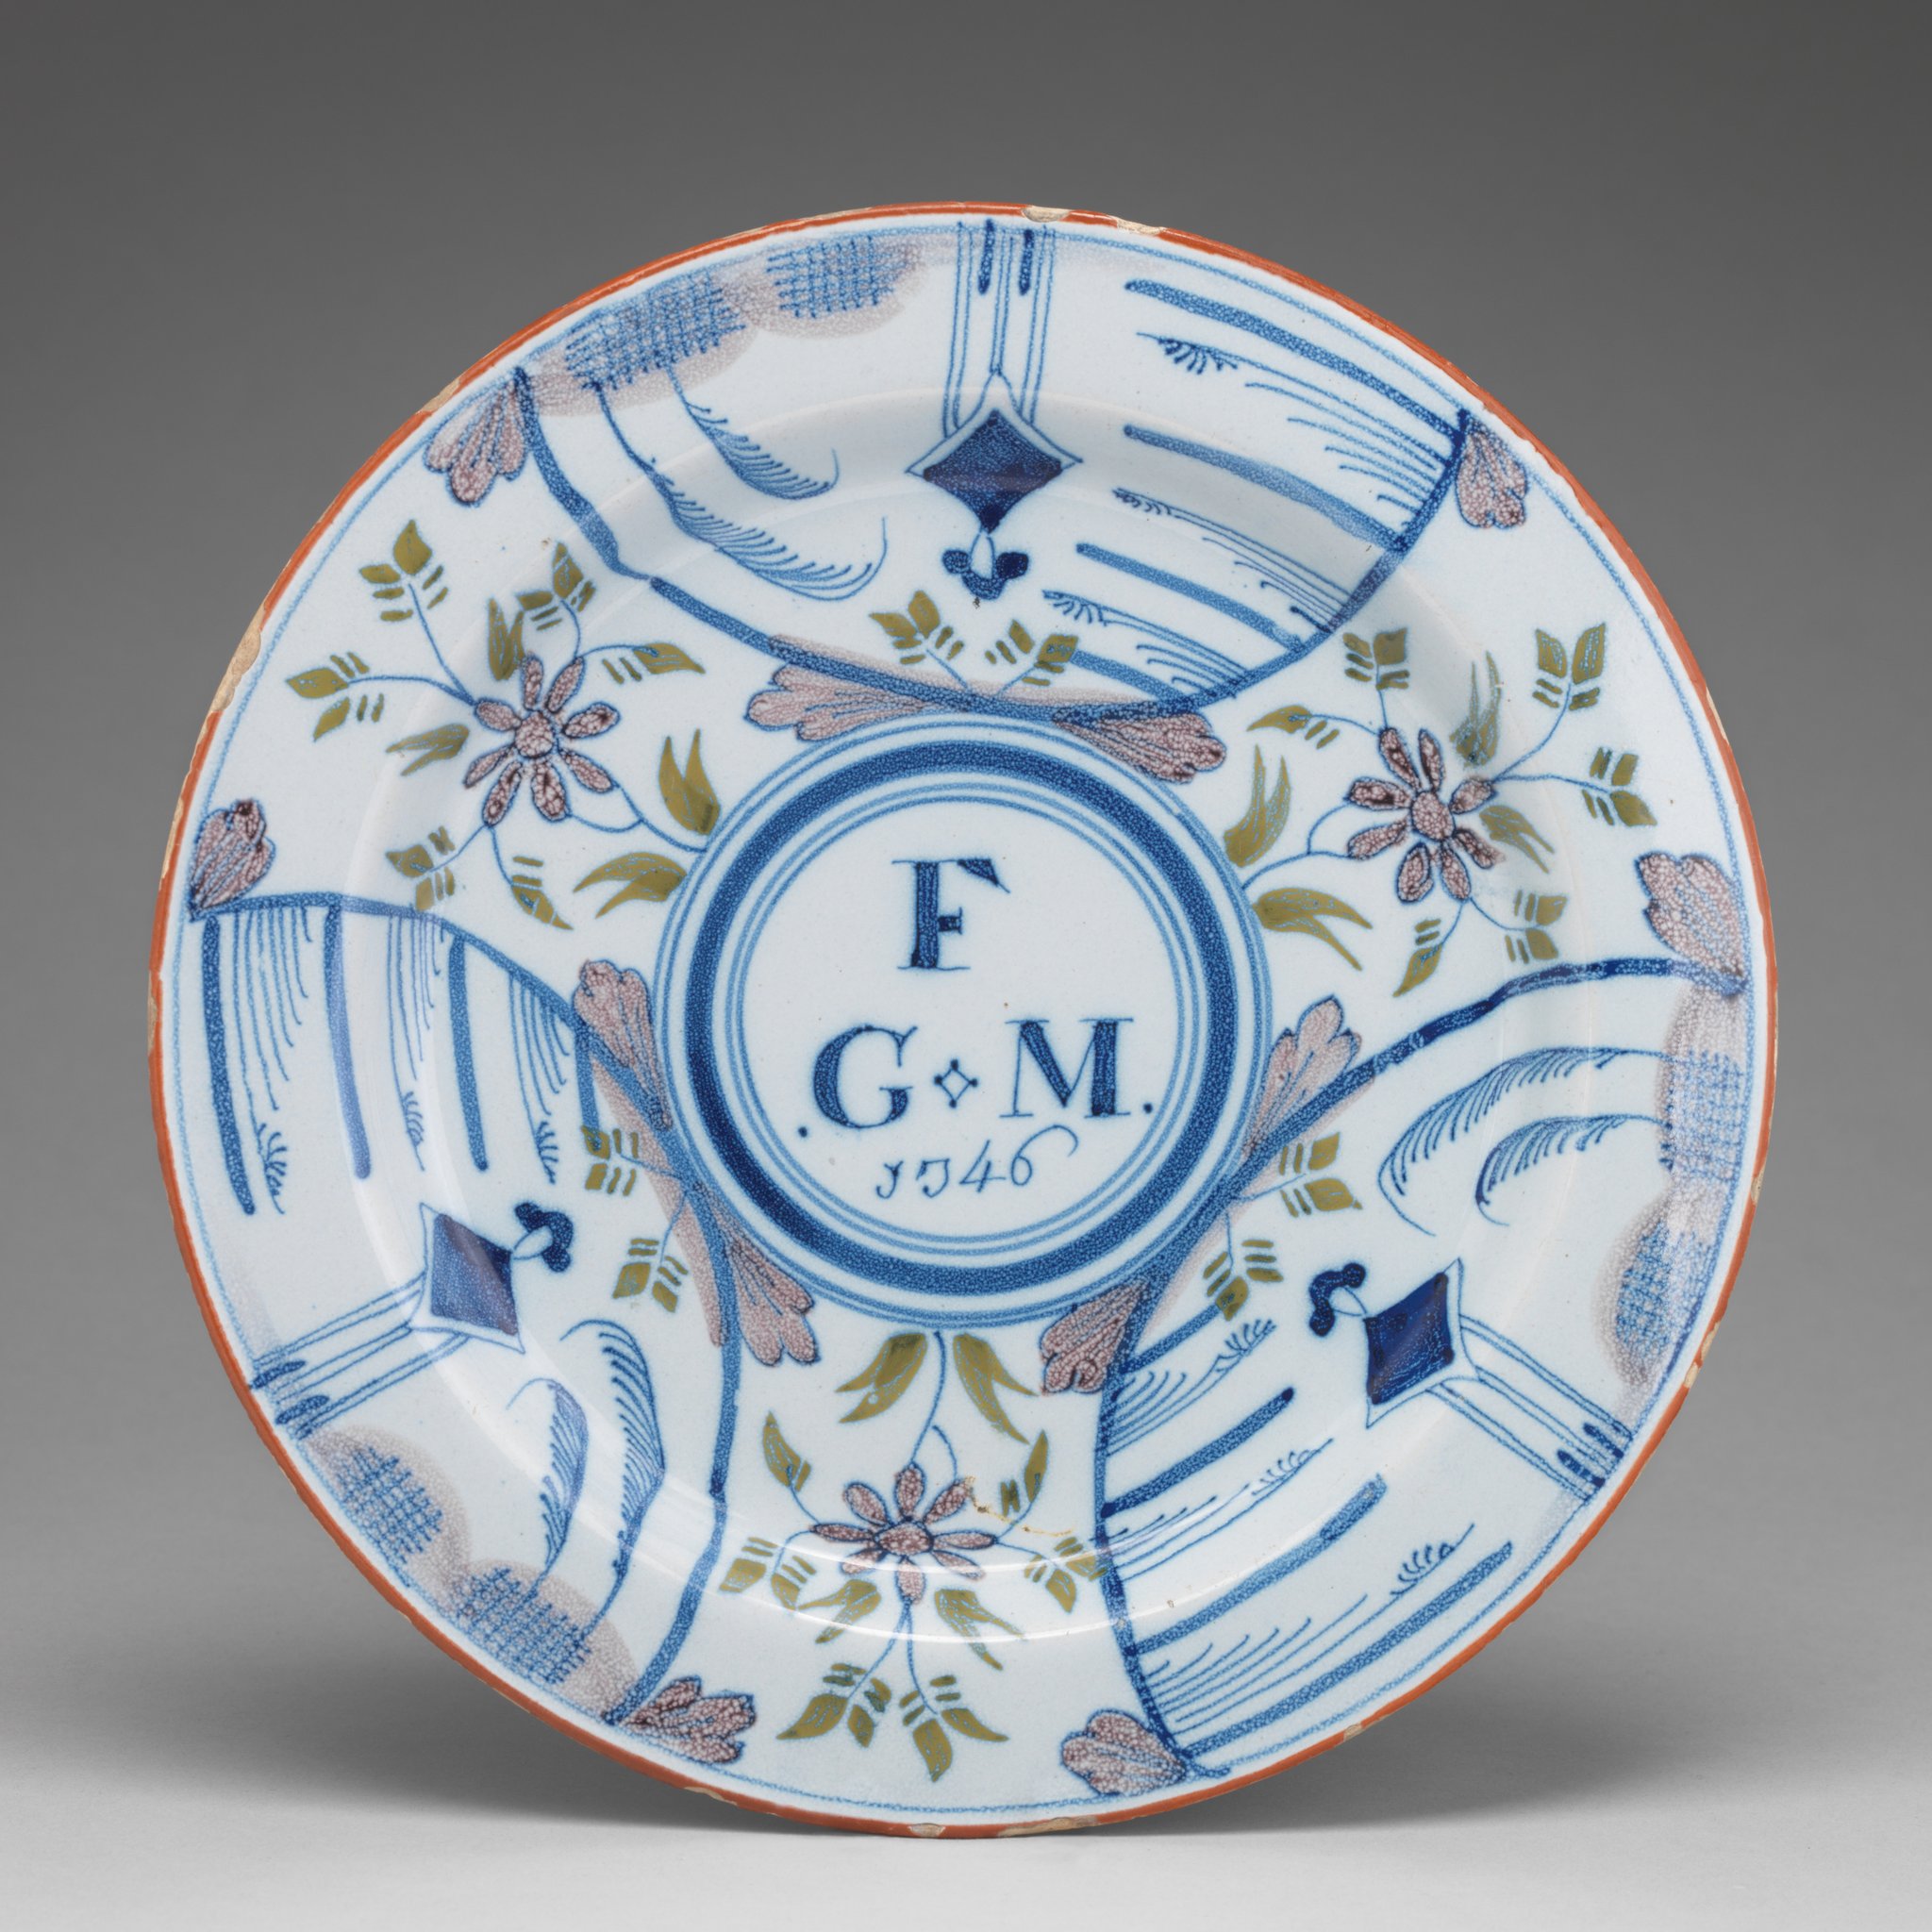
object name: plate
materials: earthenware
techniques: glazing